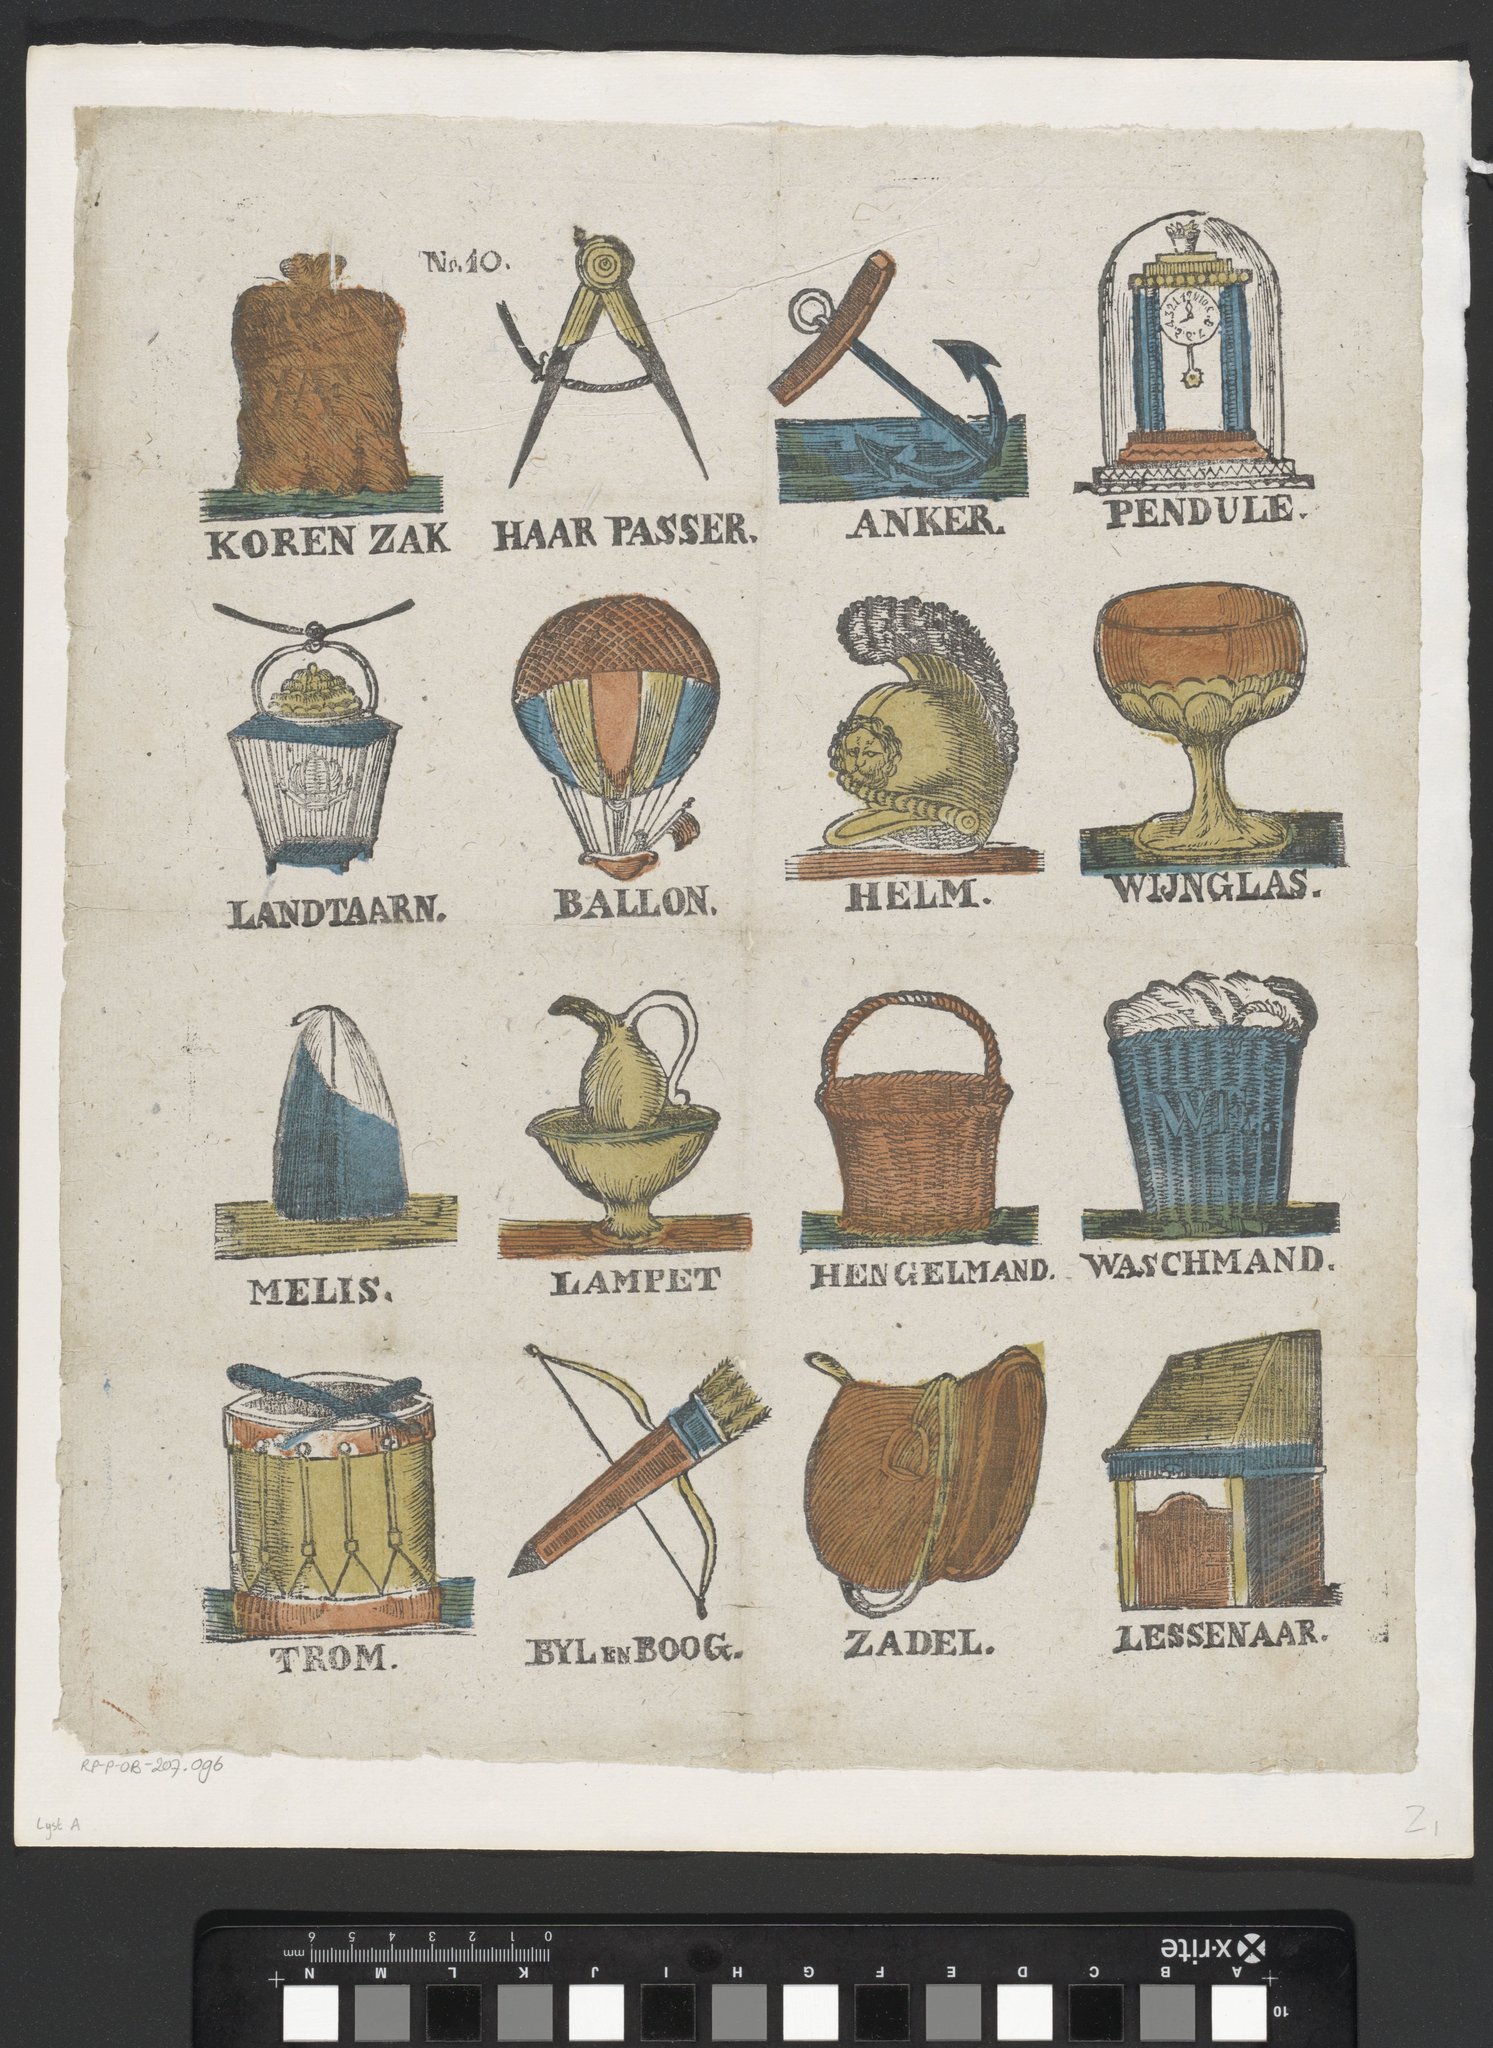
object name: popular print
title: Voorwerpen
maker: Anonymous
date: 1700-1899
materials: paper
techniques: colour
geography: netherlands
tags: drum (musical instrument), saddle, parts of ship's exterior: anchor, (household) utensils and implements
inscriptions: collector's mark: Lugt 2760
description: Blad met 8 voorstellingen van verschillende voorwerpen, zoals een zak koren, een passer en een anker. Onder elke afbeelding tekst. Genummerd linksboven: No. 10.